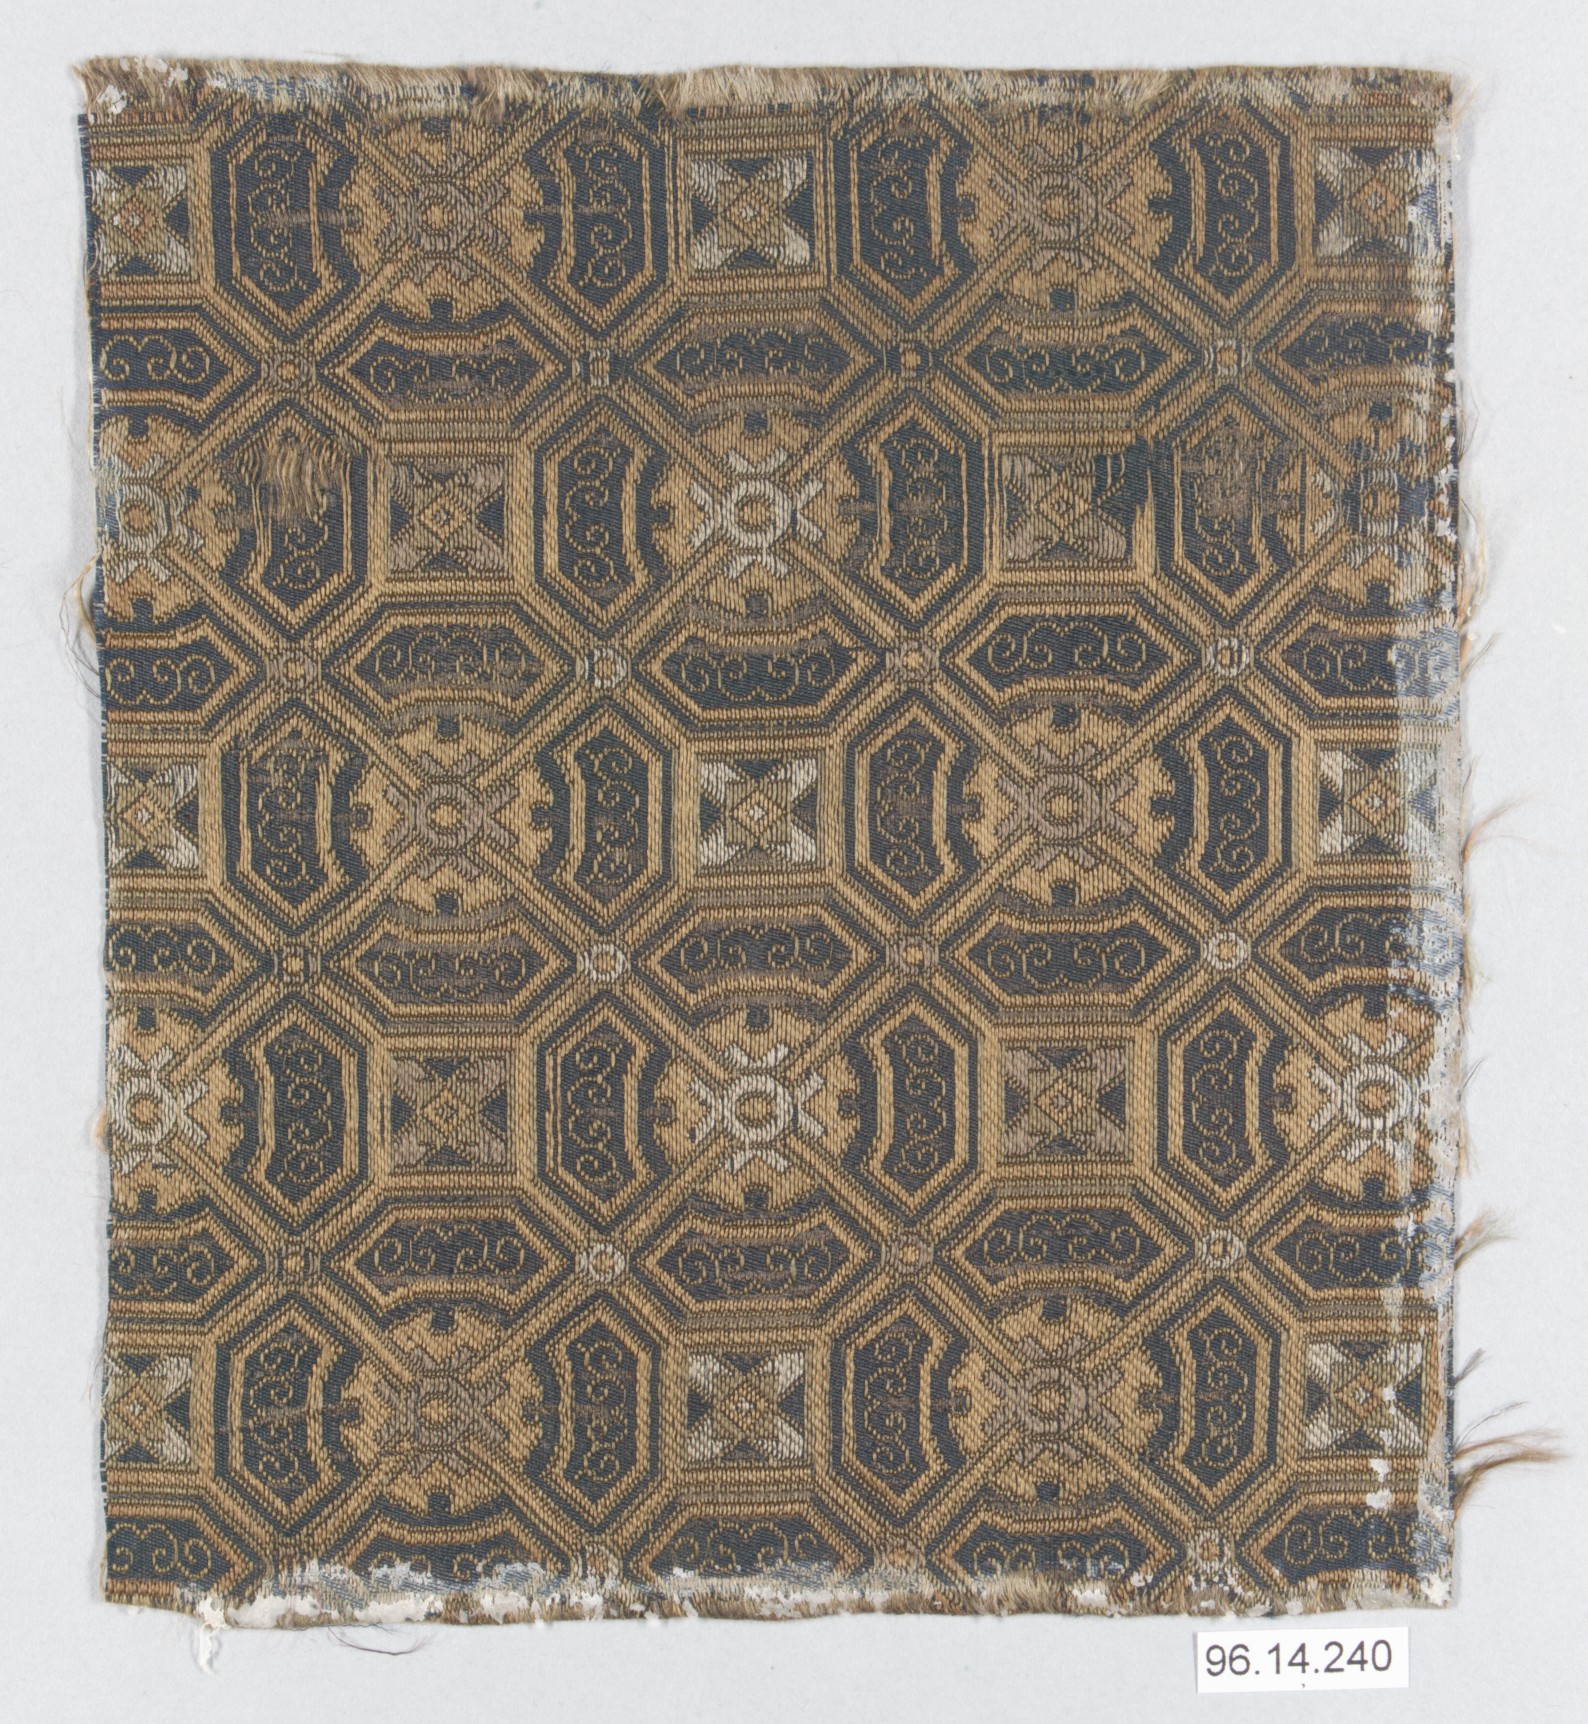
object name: piece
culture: japanese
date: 1701-1900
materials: silk